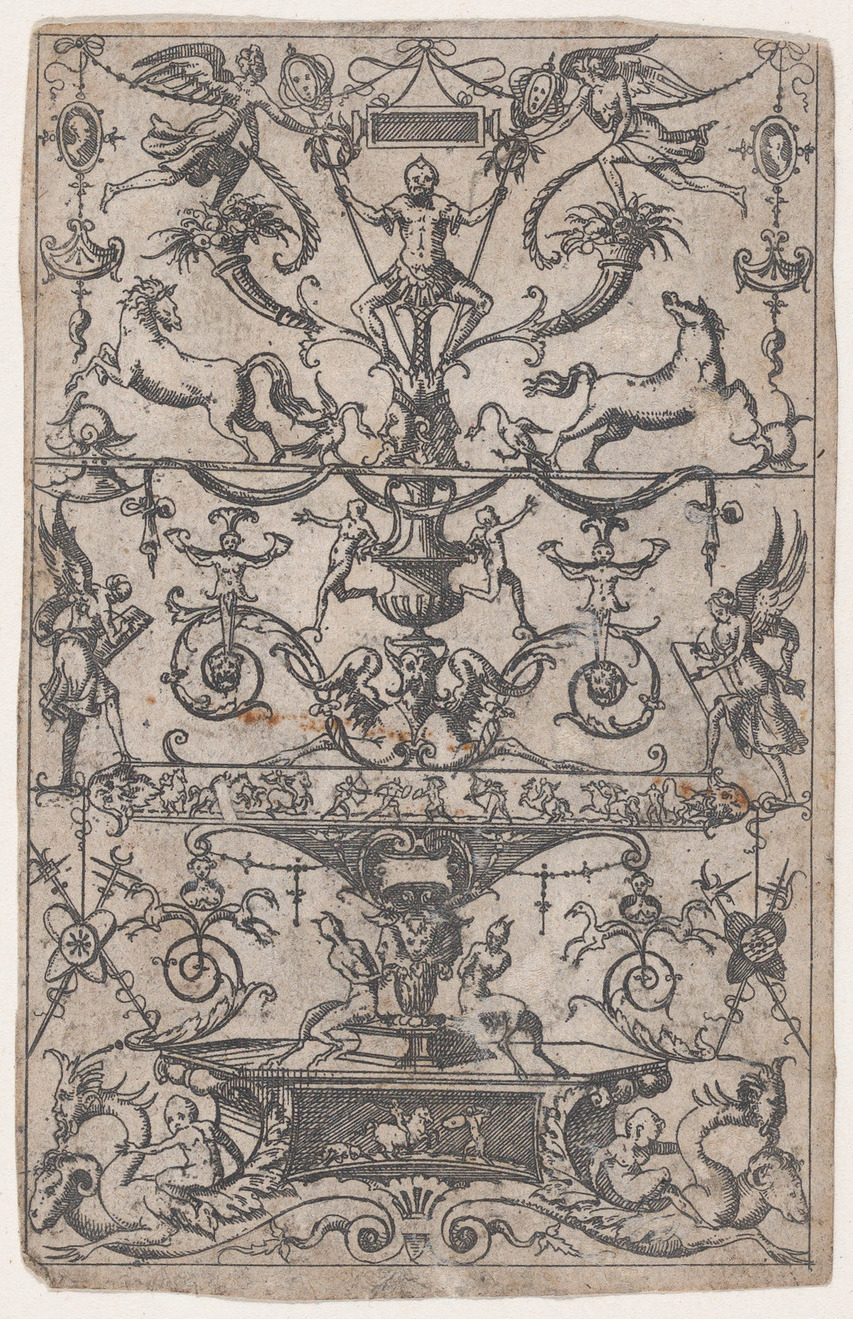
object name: print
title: Panel of Grotesques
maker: jacques androuet du cerceau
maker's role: artist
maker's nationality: french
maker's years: 1510-1585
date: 1530-1585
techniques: etching